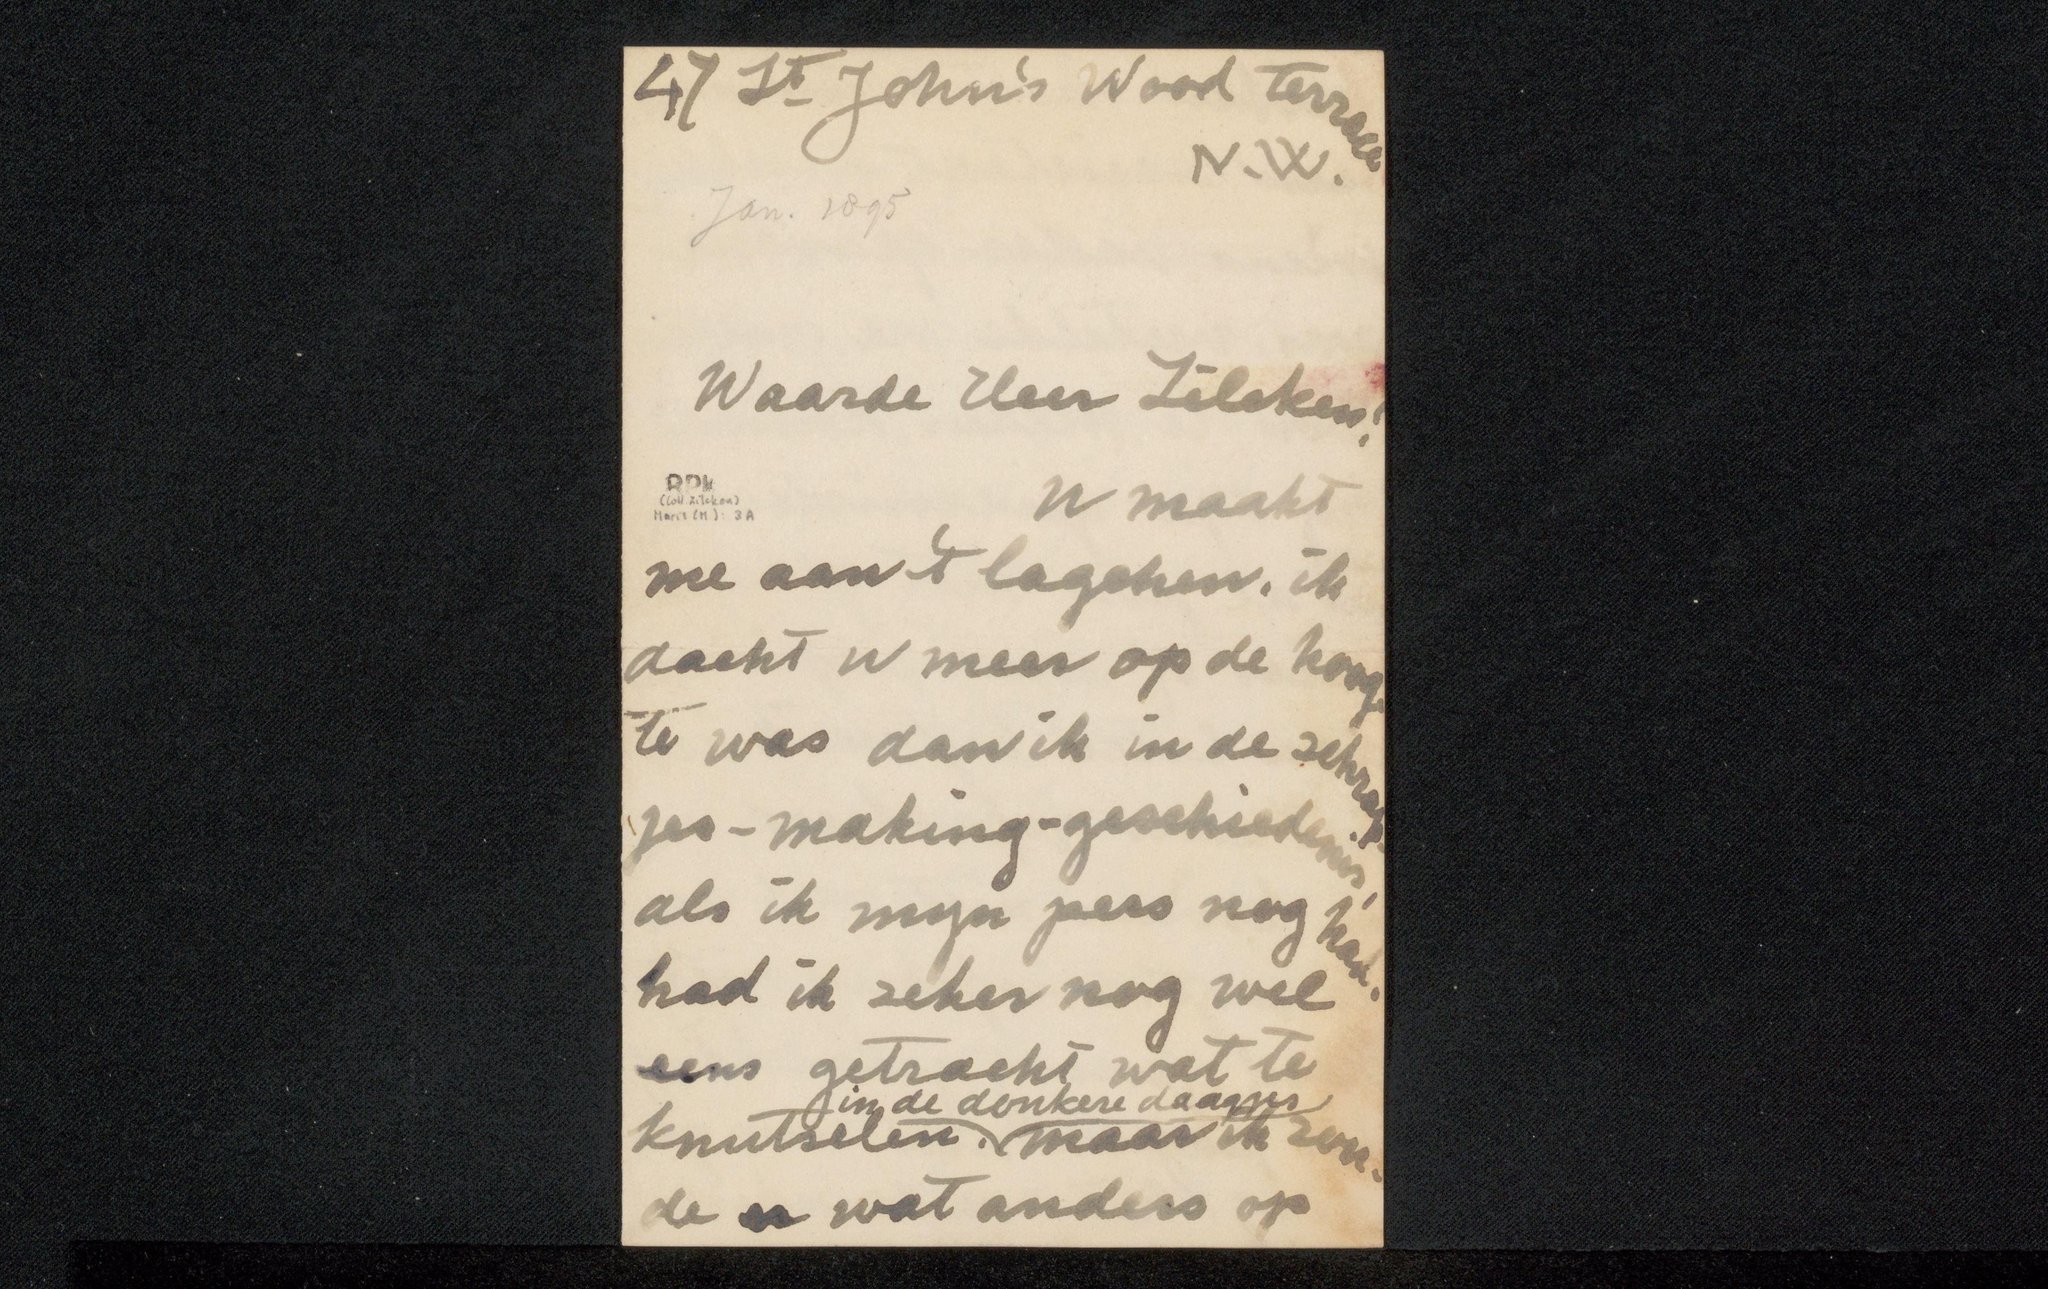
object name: letter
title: Brief aan Philip Zilcken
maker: matthijs maris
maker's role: draughtsman, painter, print maker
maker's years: 1839-1917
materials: ink, paper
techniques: pen, writing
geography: london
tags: johan hendrik weissenbruch, maxime françois antoine lalanne, the hague, painter, draughtsman, philip zilcken, the graphic arts, painting (including book-illumination, miniature-painting)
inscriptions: collector's mark: ‘RPK’